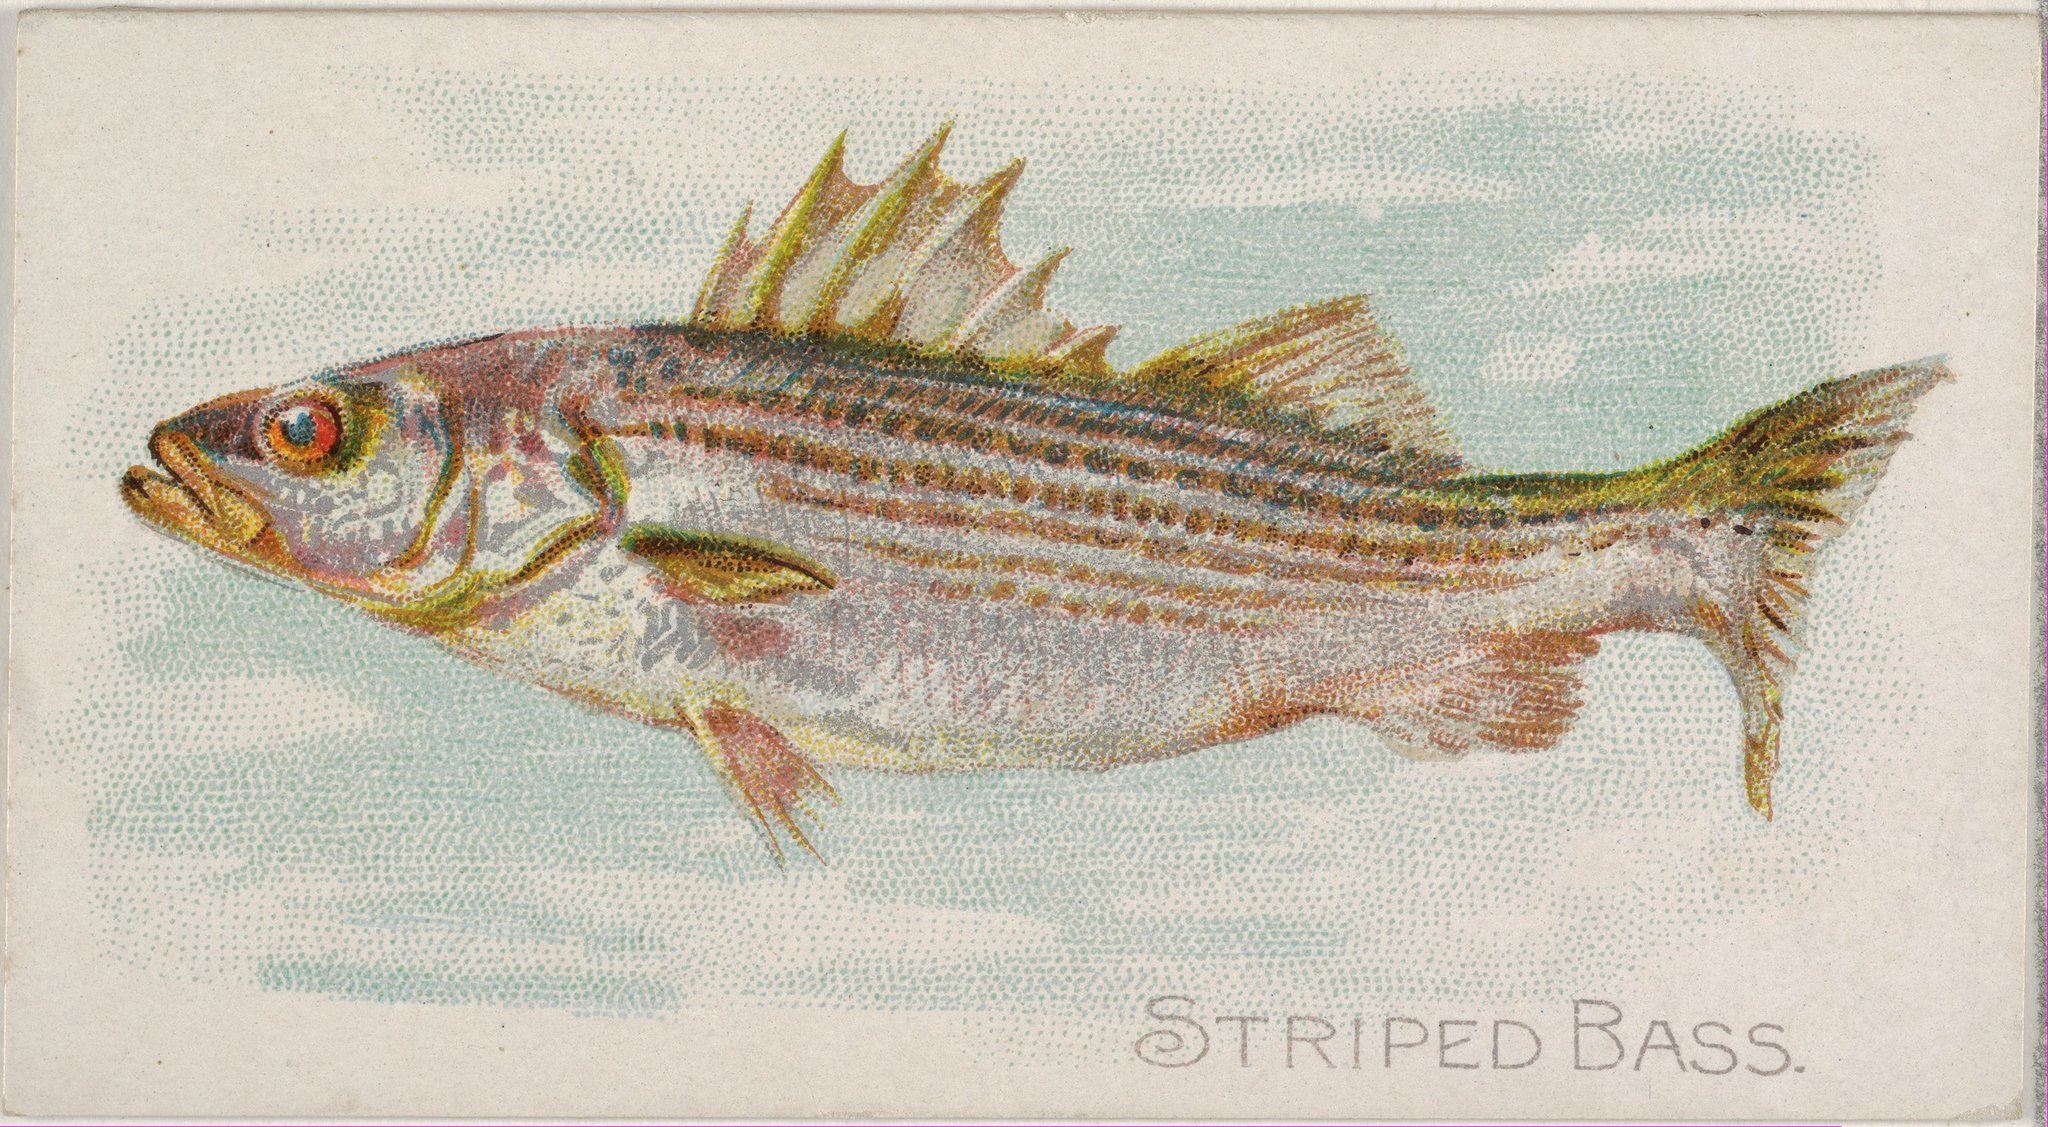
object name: print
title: Striped Bass, from the Fish from American Waters series (N8) for Allen & Ginter Cigarettes Brands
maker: allen & ginter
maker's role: publisher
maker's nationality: american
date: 1889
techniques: color lithograph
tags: fish